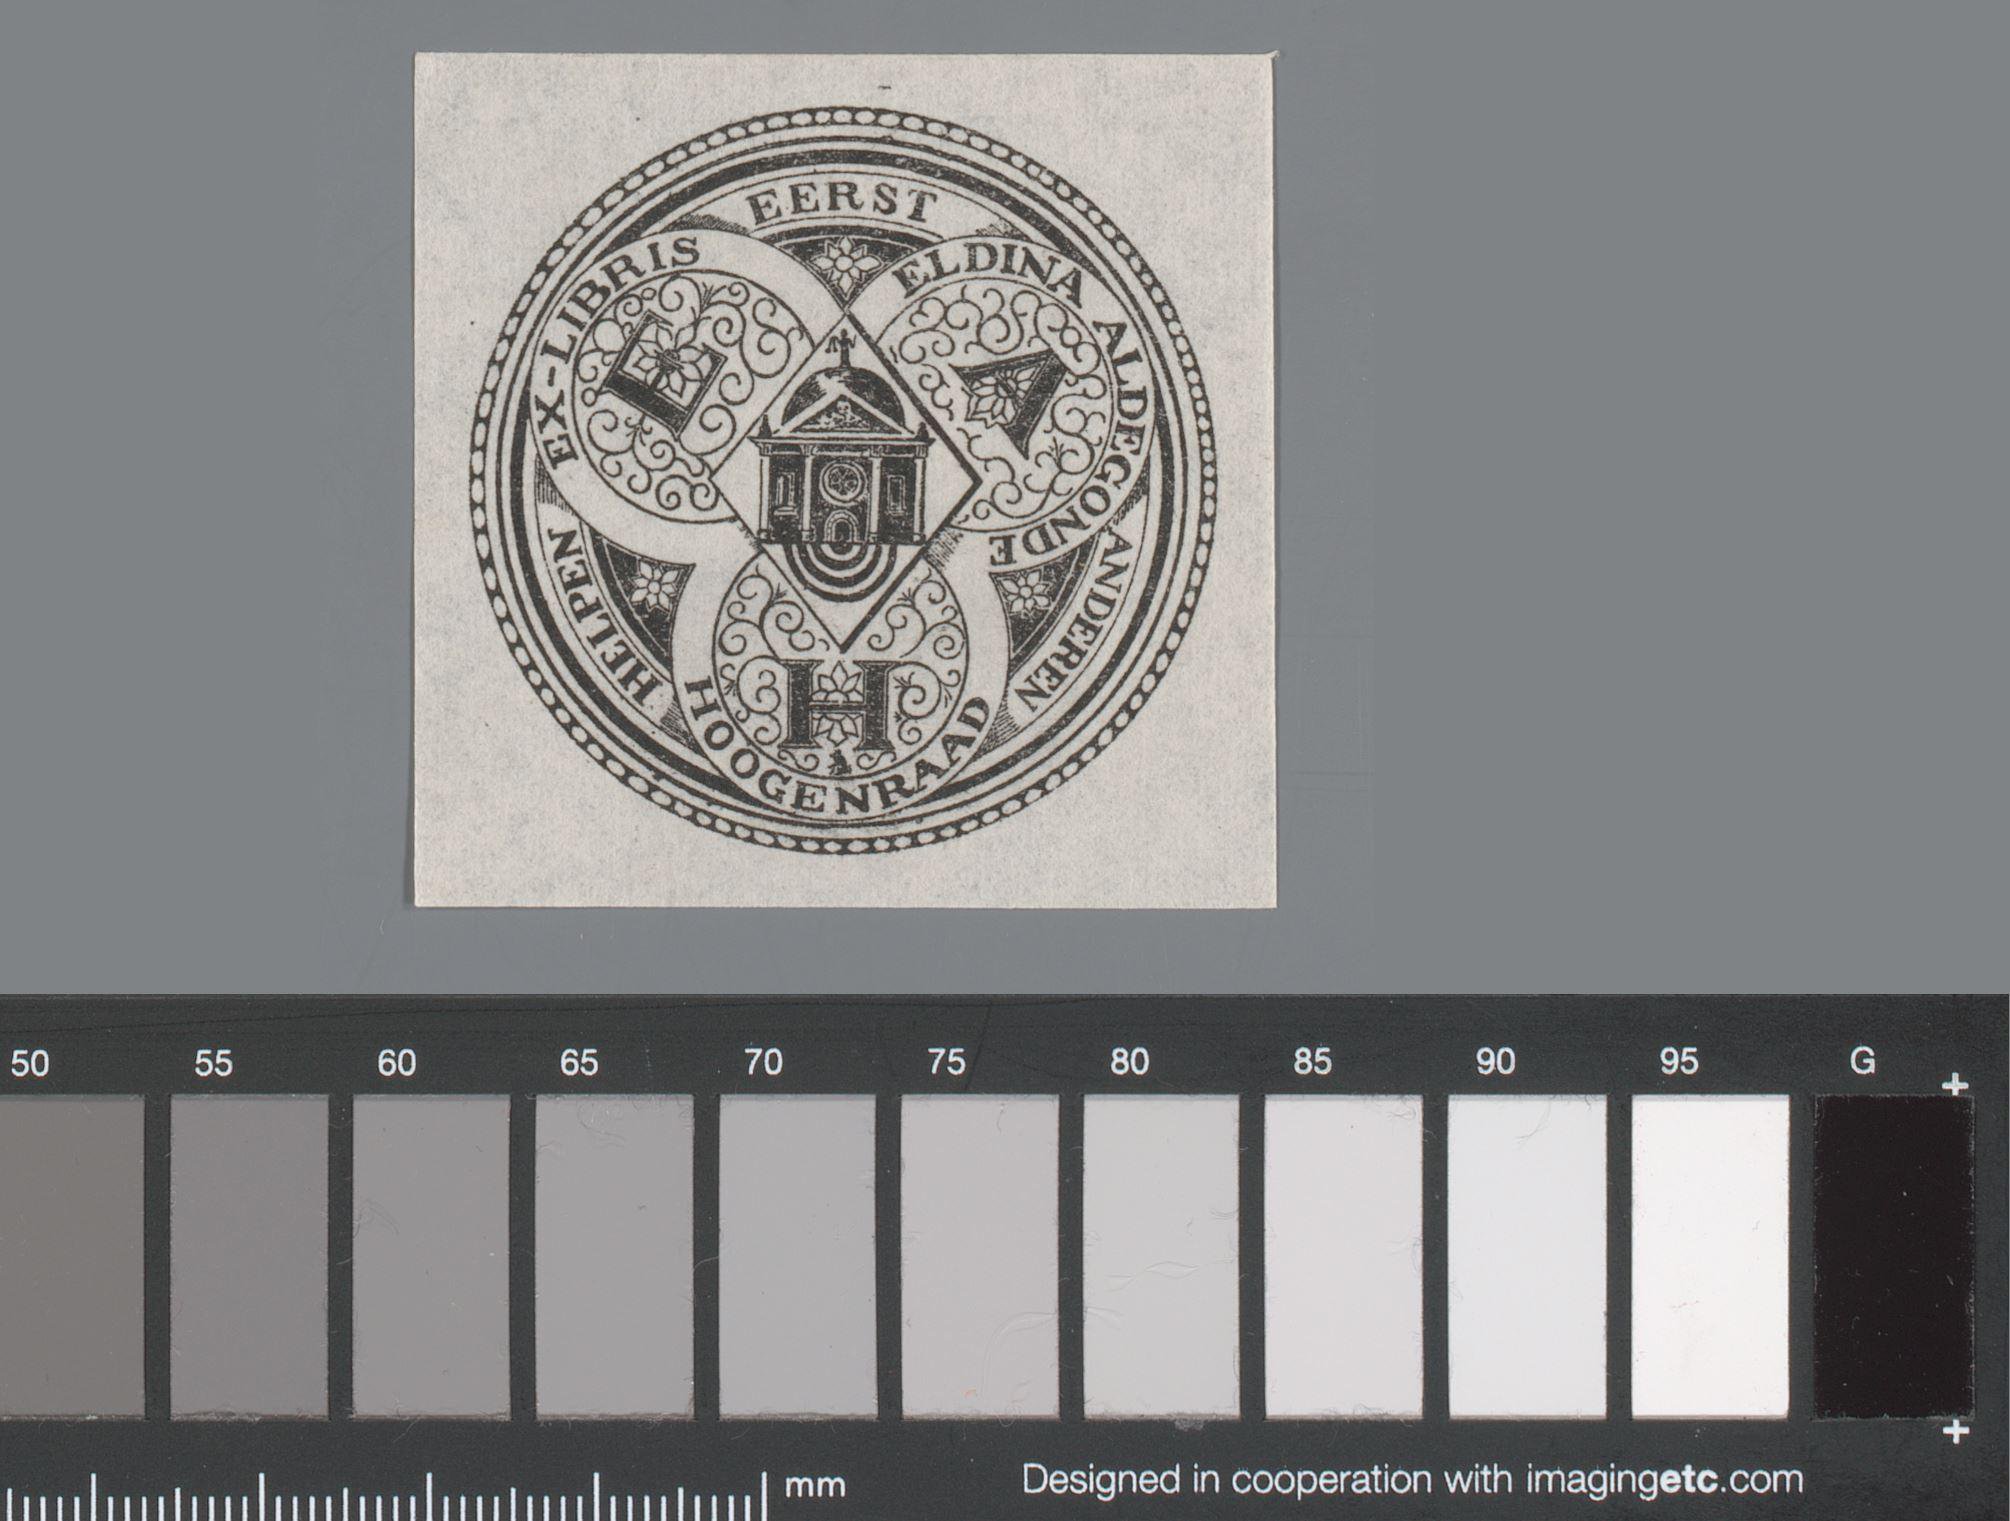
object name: bookplate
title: Ex libris van Eldina Aldegonda Hoogenraad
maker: Anonymous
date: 1948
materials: paper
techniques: printing block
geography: netherlands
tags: haarlem, parts of church exterior and annexes